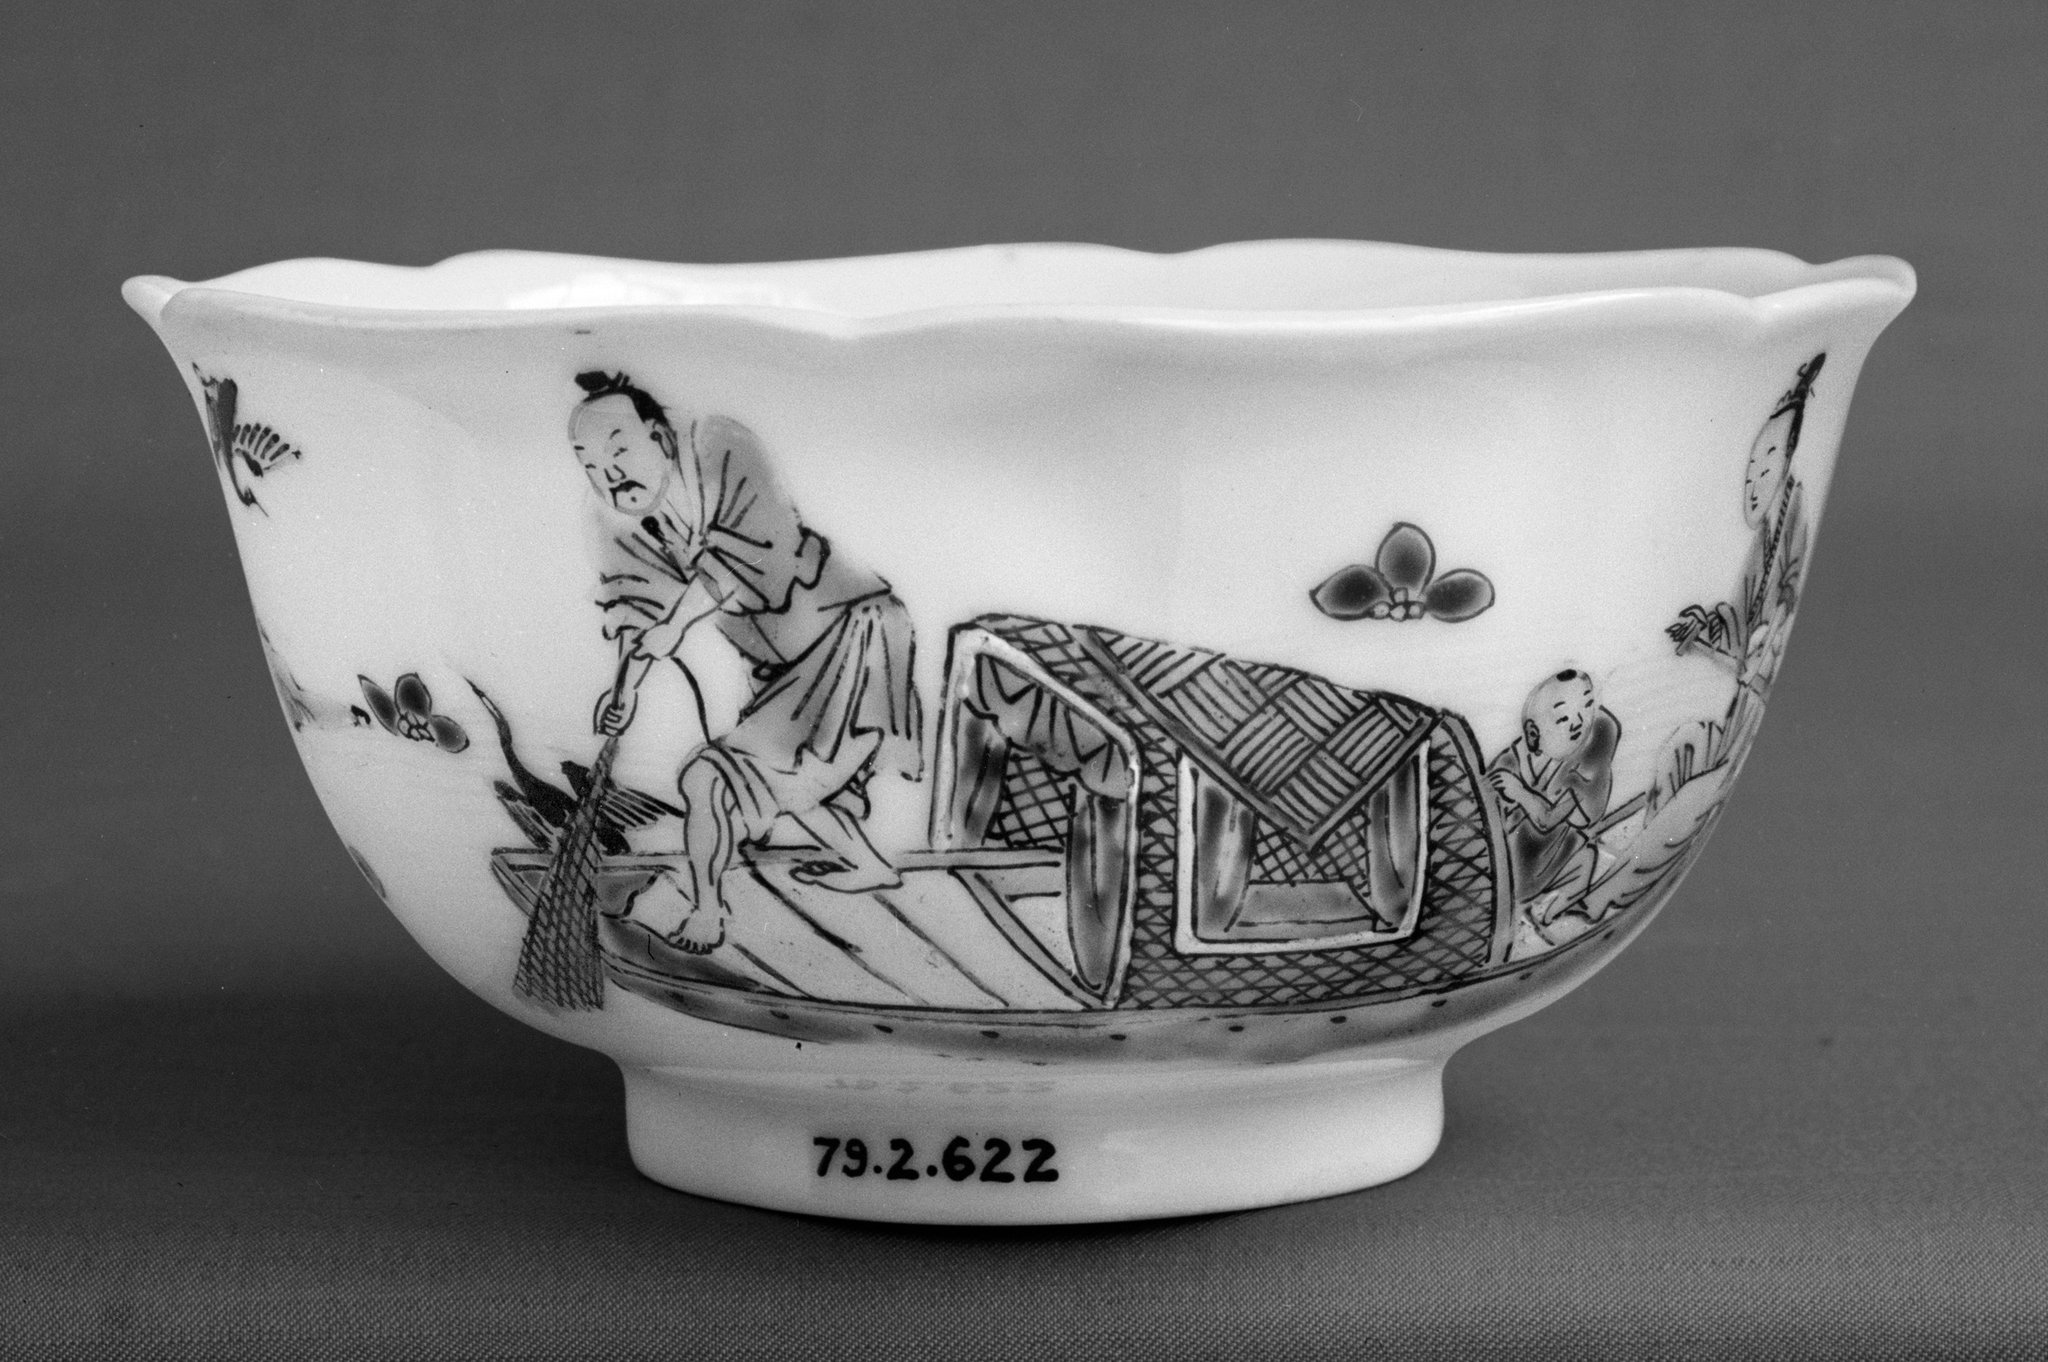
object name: cup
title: Cup with figures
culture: chinese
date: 1701-1800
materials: enamel, porcelain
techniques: overglaze, painting, polychrome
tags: men,boats